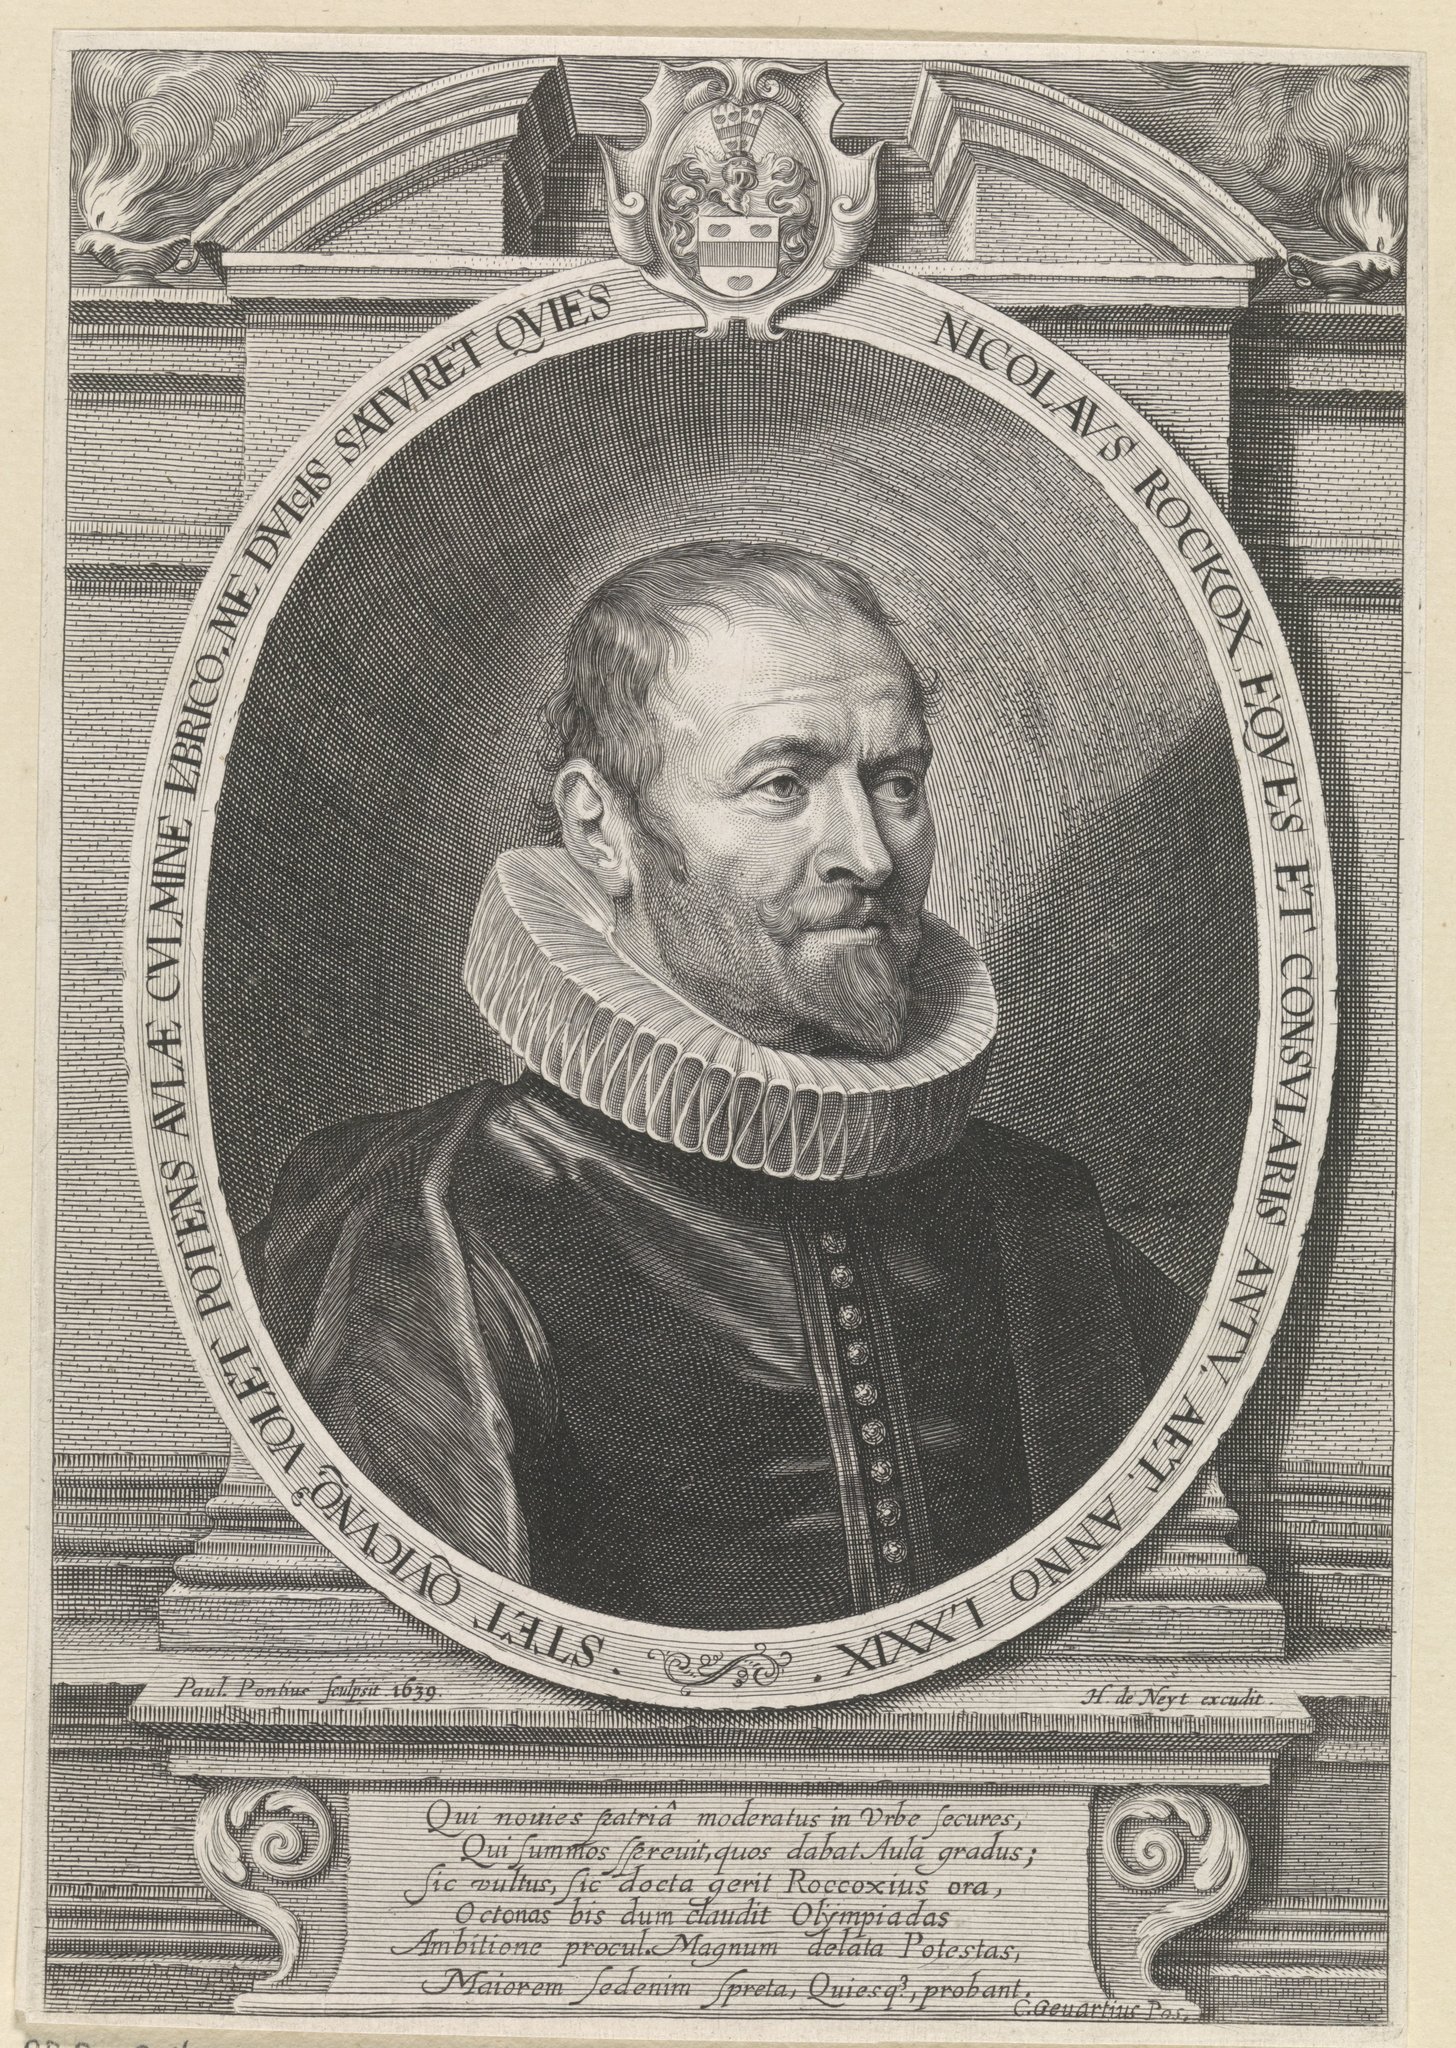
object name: print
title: Portret van Nicolaas Rockox jr., op 79-jarige leeftijd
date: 1639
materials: paper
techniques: engraving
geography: antwerp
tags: antwerp, mayor, nikolaas rockox, armorial bearing, heraldry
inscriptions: collector's mark: Lugt 240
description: Portret van Nicolaas Rockox jr., burgemeester van Antwerpen, bekroond met zijn wapenschild. In het kader op de piëdestal een zesregelig lofdicht in het Latijn.